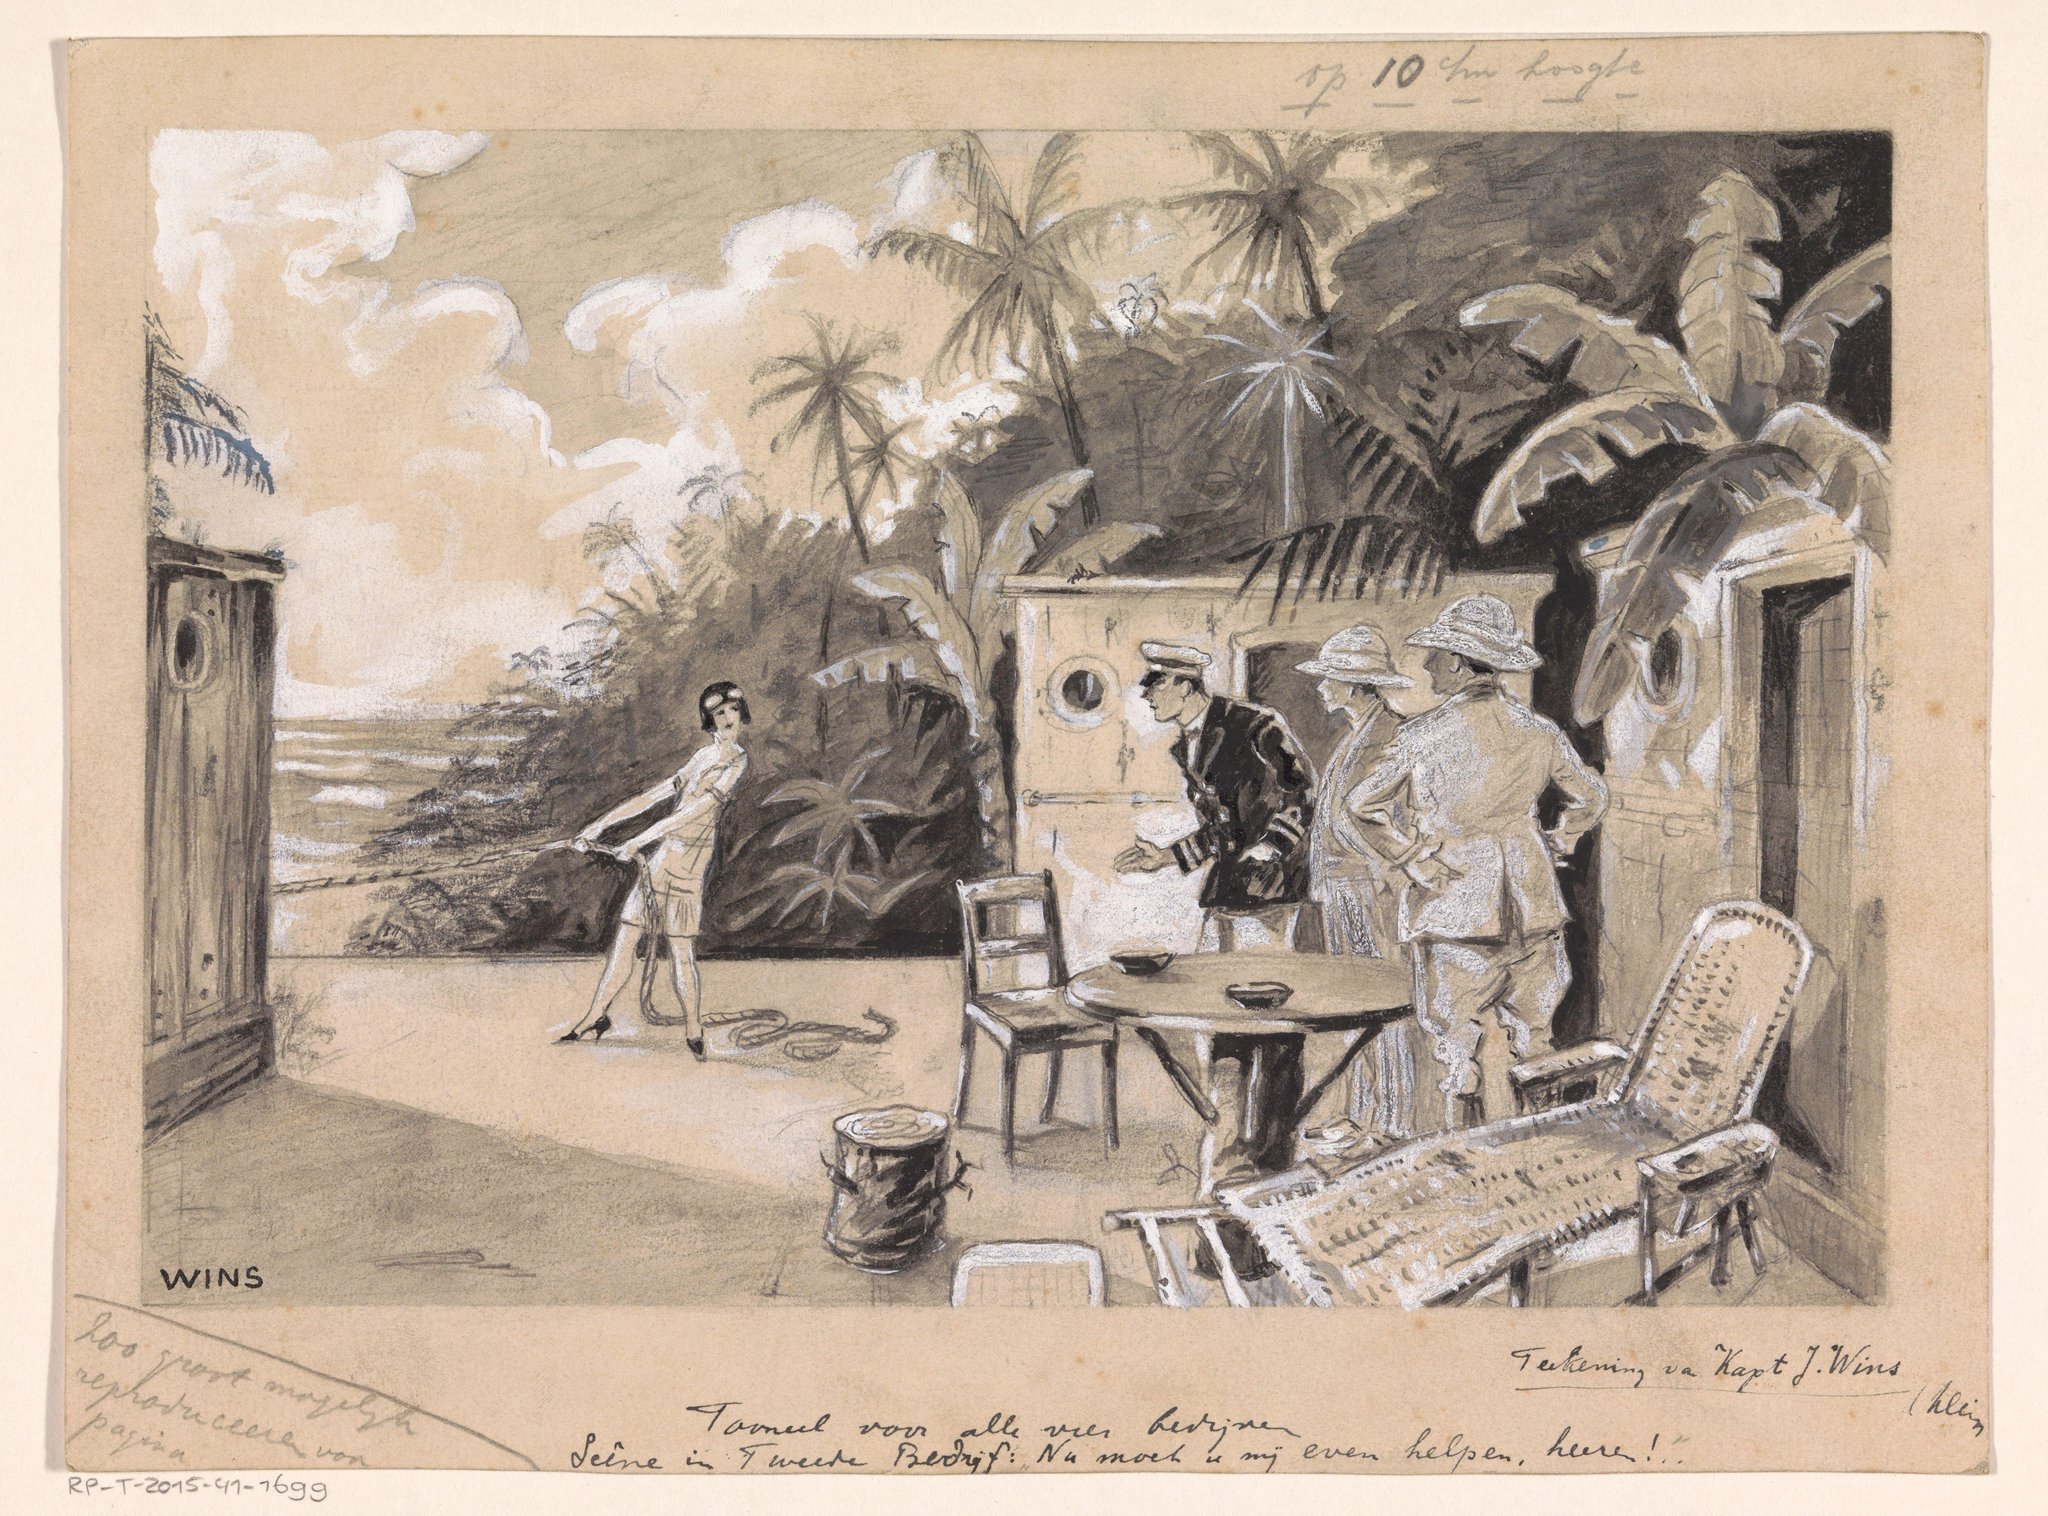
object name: drawing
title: Vrouw met touw vraagt mannen om hulp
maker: jos wins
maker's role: draughtsman, print maker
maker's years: 1881-1940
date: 1891-1940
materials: paint, ink, paper, pencil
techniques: brush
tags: seaman (with name of rank), landscapes in tropical and sub-tropical regions (+ landscape (in the non-temperate zone) with figures, staffage), tools, aids, implements ~ crafts and industries: rope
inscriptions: :, signature: ‘WINS’, annotation: ‘Teekening van Kapt J. Wins/ (Klein/ Tooneel voor alle vier bedrijven/ Scène in Tweede Bedrijf: Nu moet u mij even helpen, heeren!..’, collector's mark: Lugt 2228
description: In een tropisch landschap met palmbomen en in de verte een zee staat een vrouw in een korte jurk op een terras. Ze trekt aan een touw en draait zich om naar drie mannen, onder wie één kapitein, die op het terras staan bij een tafel en ligstoel.